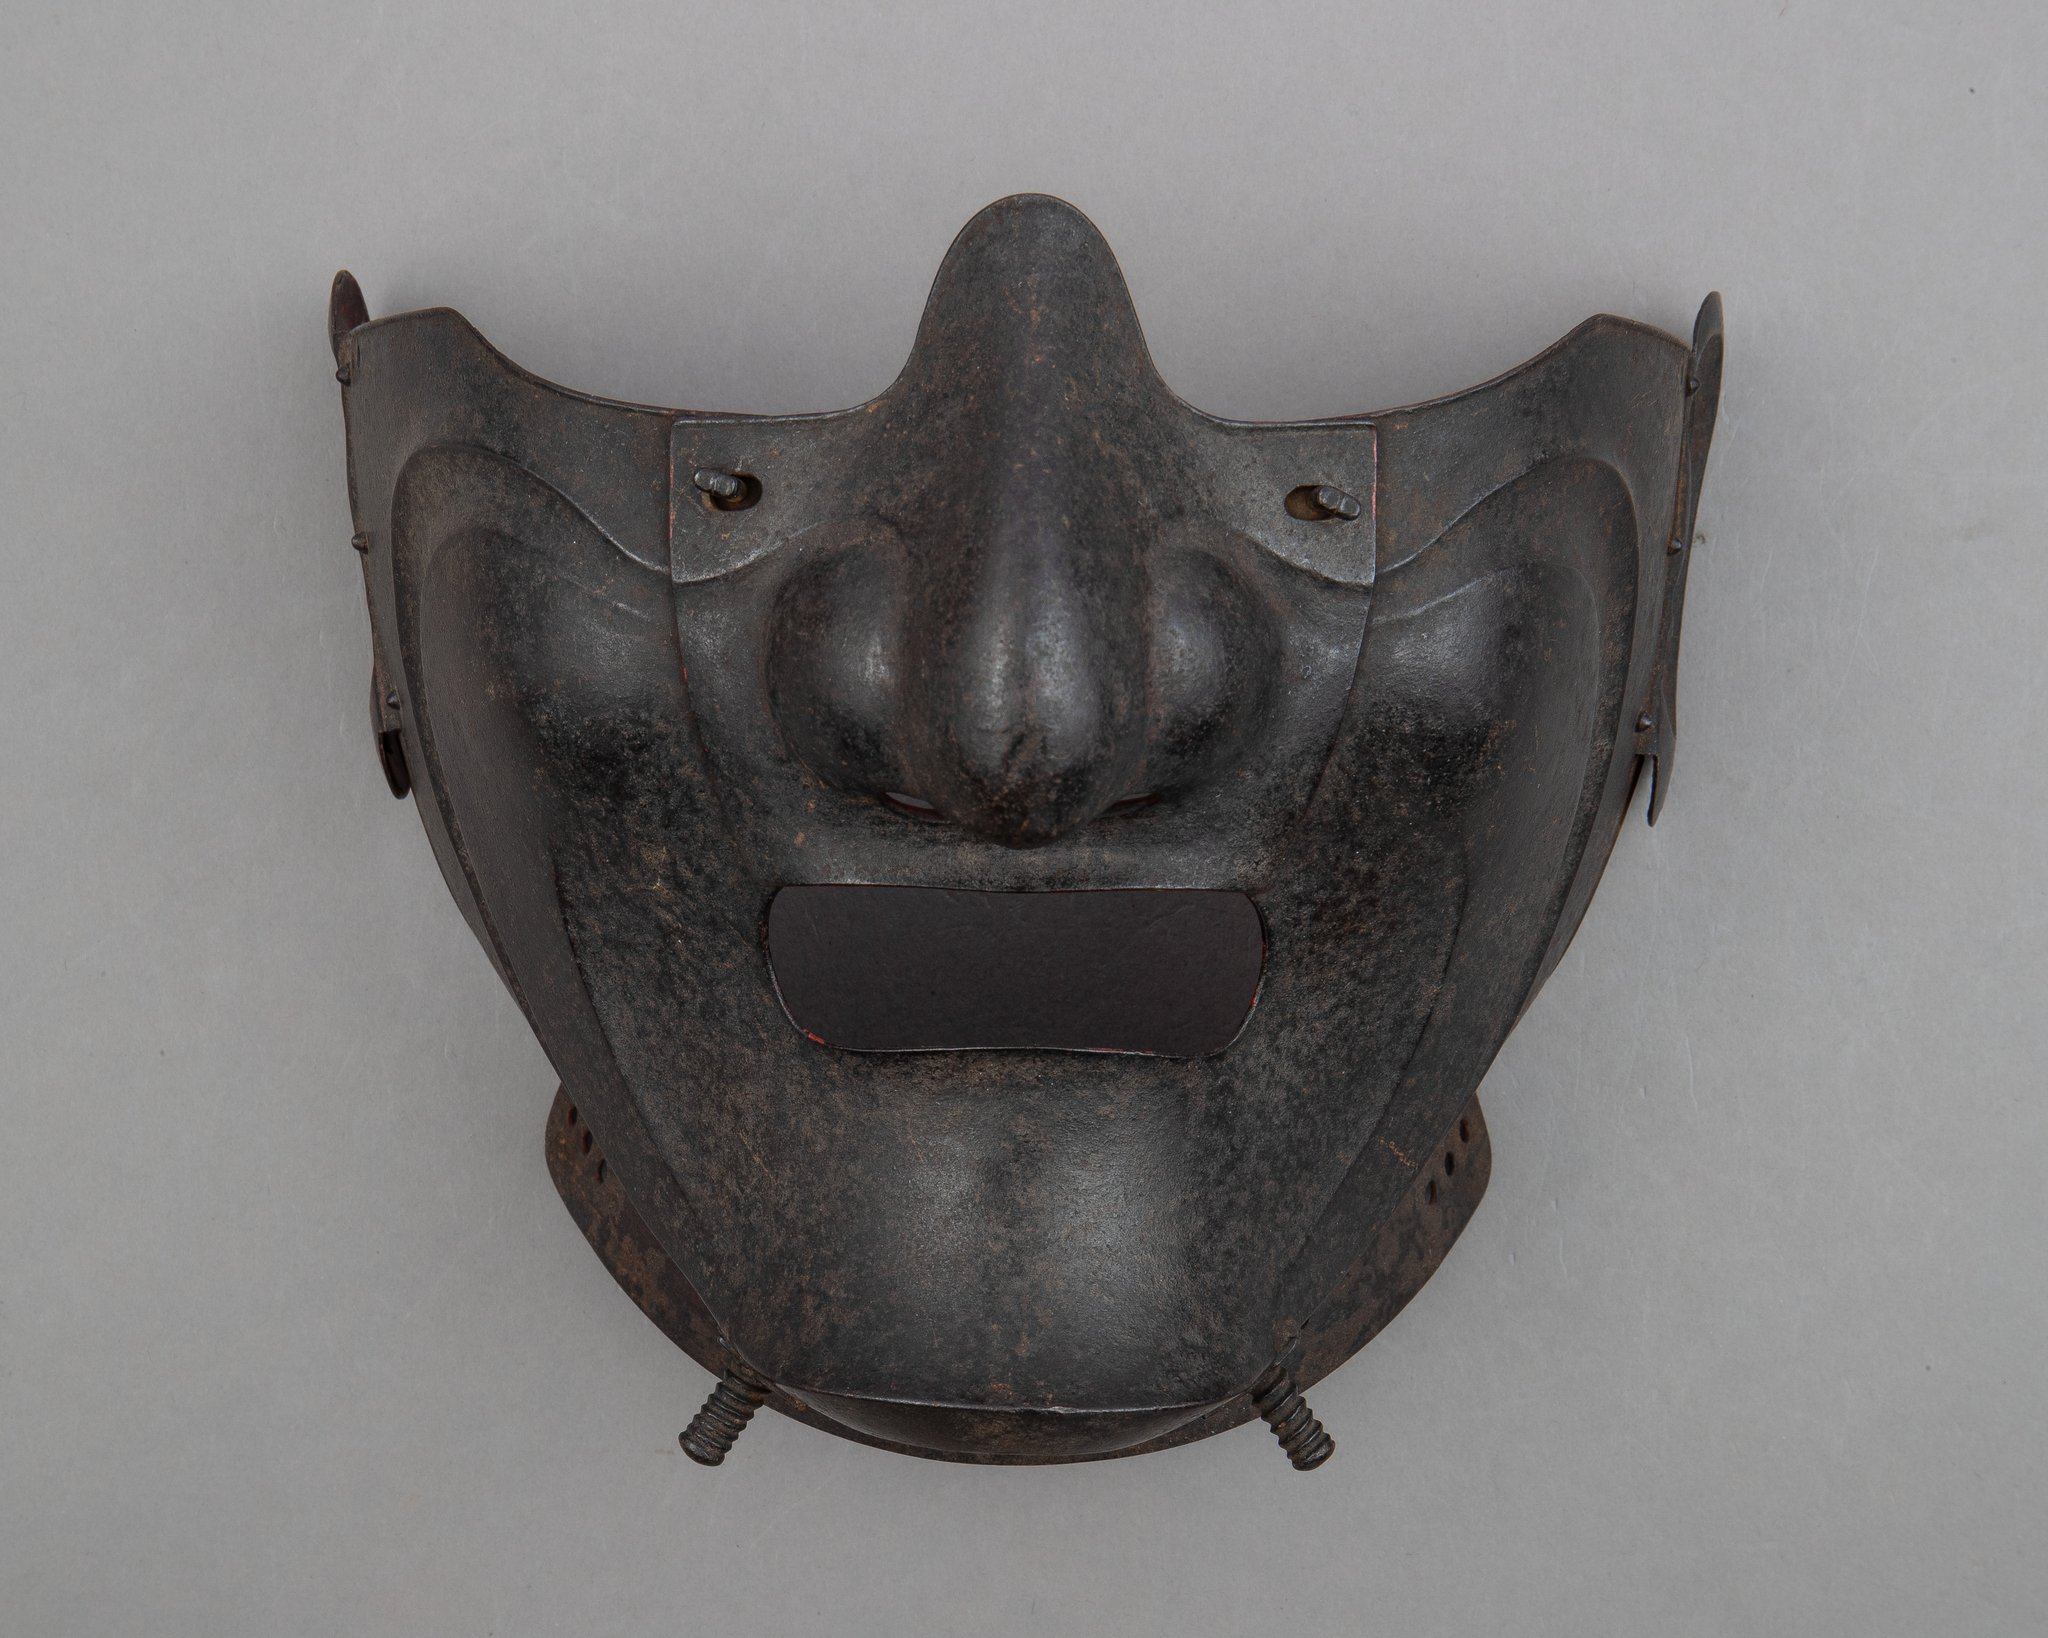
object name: half mask menpō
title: Half Mask (Menpō)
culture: japanese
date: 1615-1868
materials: iron, lacquer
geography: japan